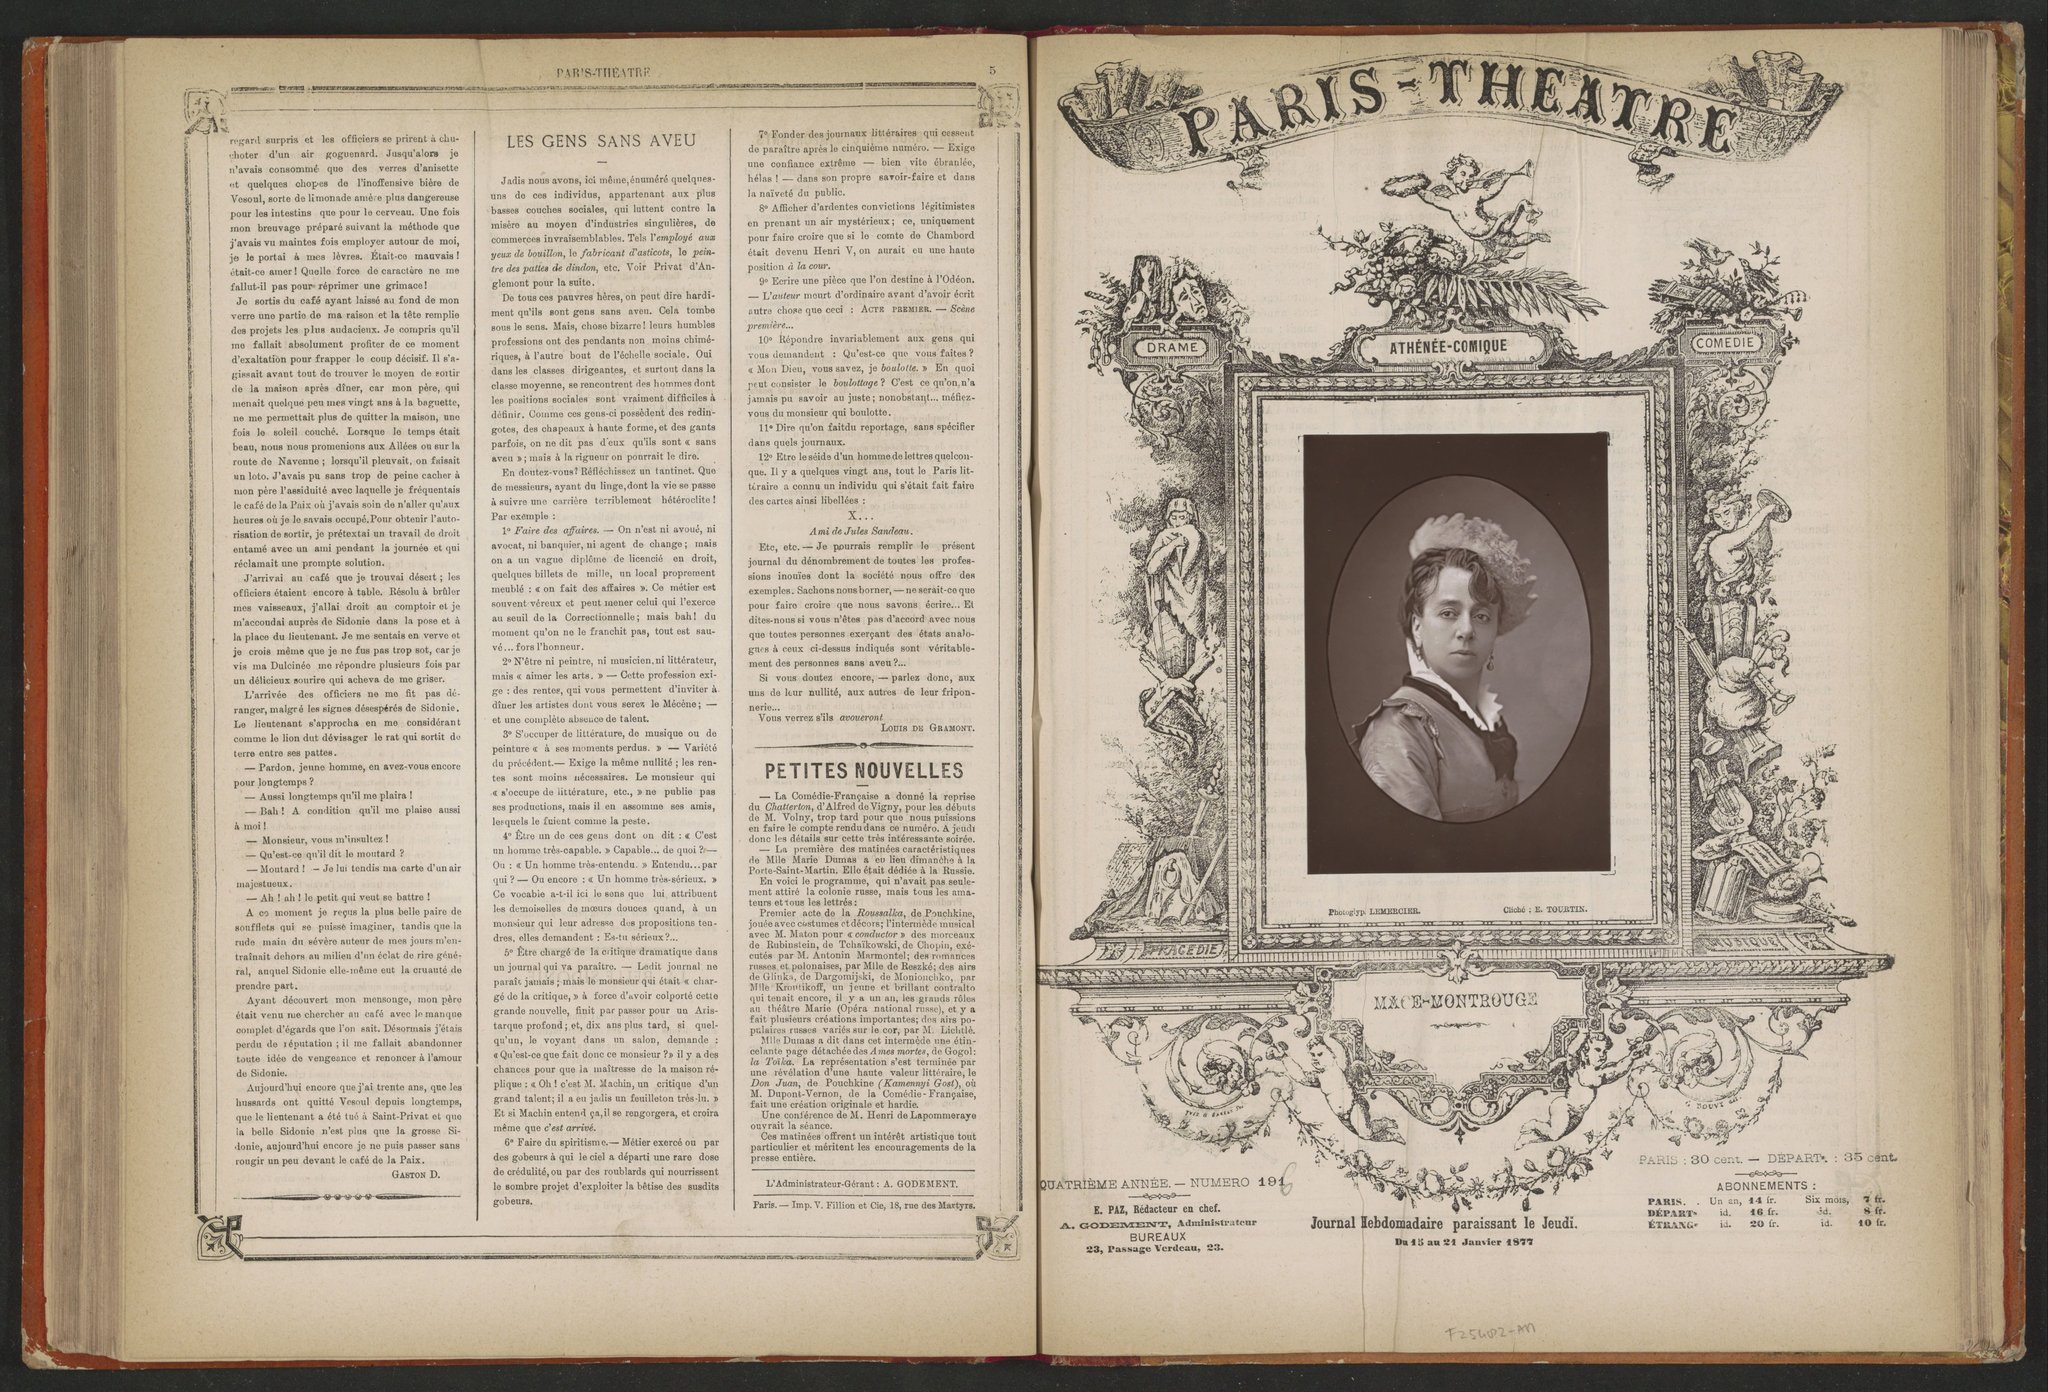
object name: page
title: Mace-Montrouge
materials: paper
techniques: woodburytype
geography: paris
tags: portrait of opera-singer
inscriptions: inscription: ‘Journal Hebdomadaire paraissant le Jeudi, Du 15 au 21 Février 1877’, number: ‘Numéro 196’